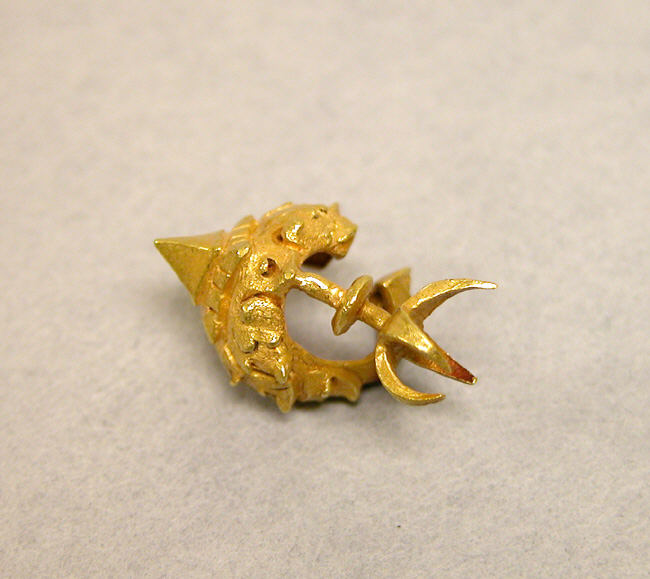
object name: ear ornament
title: Ear Ornament Pennanular Hook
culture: indonesian, central java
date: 701-1200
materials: gold